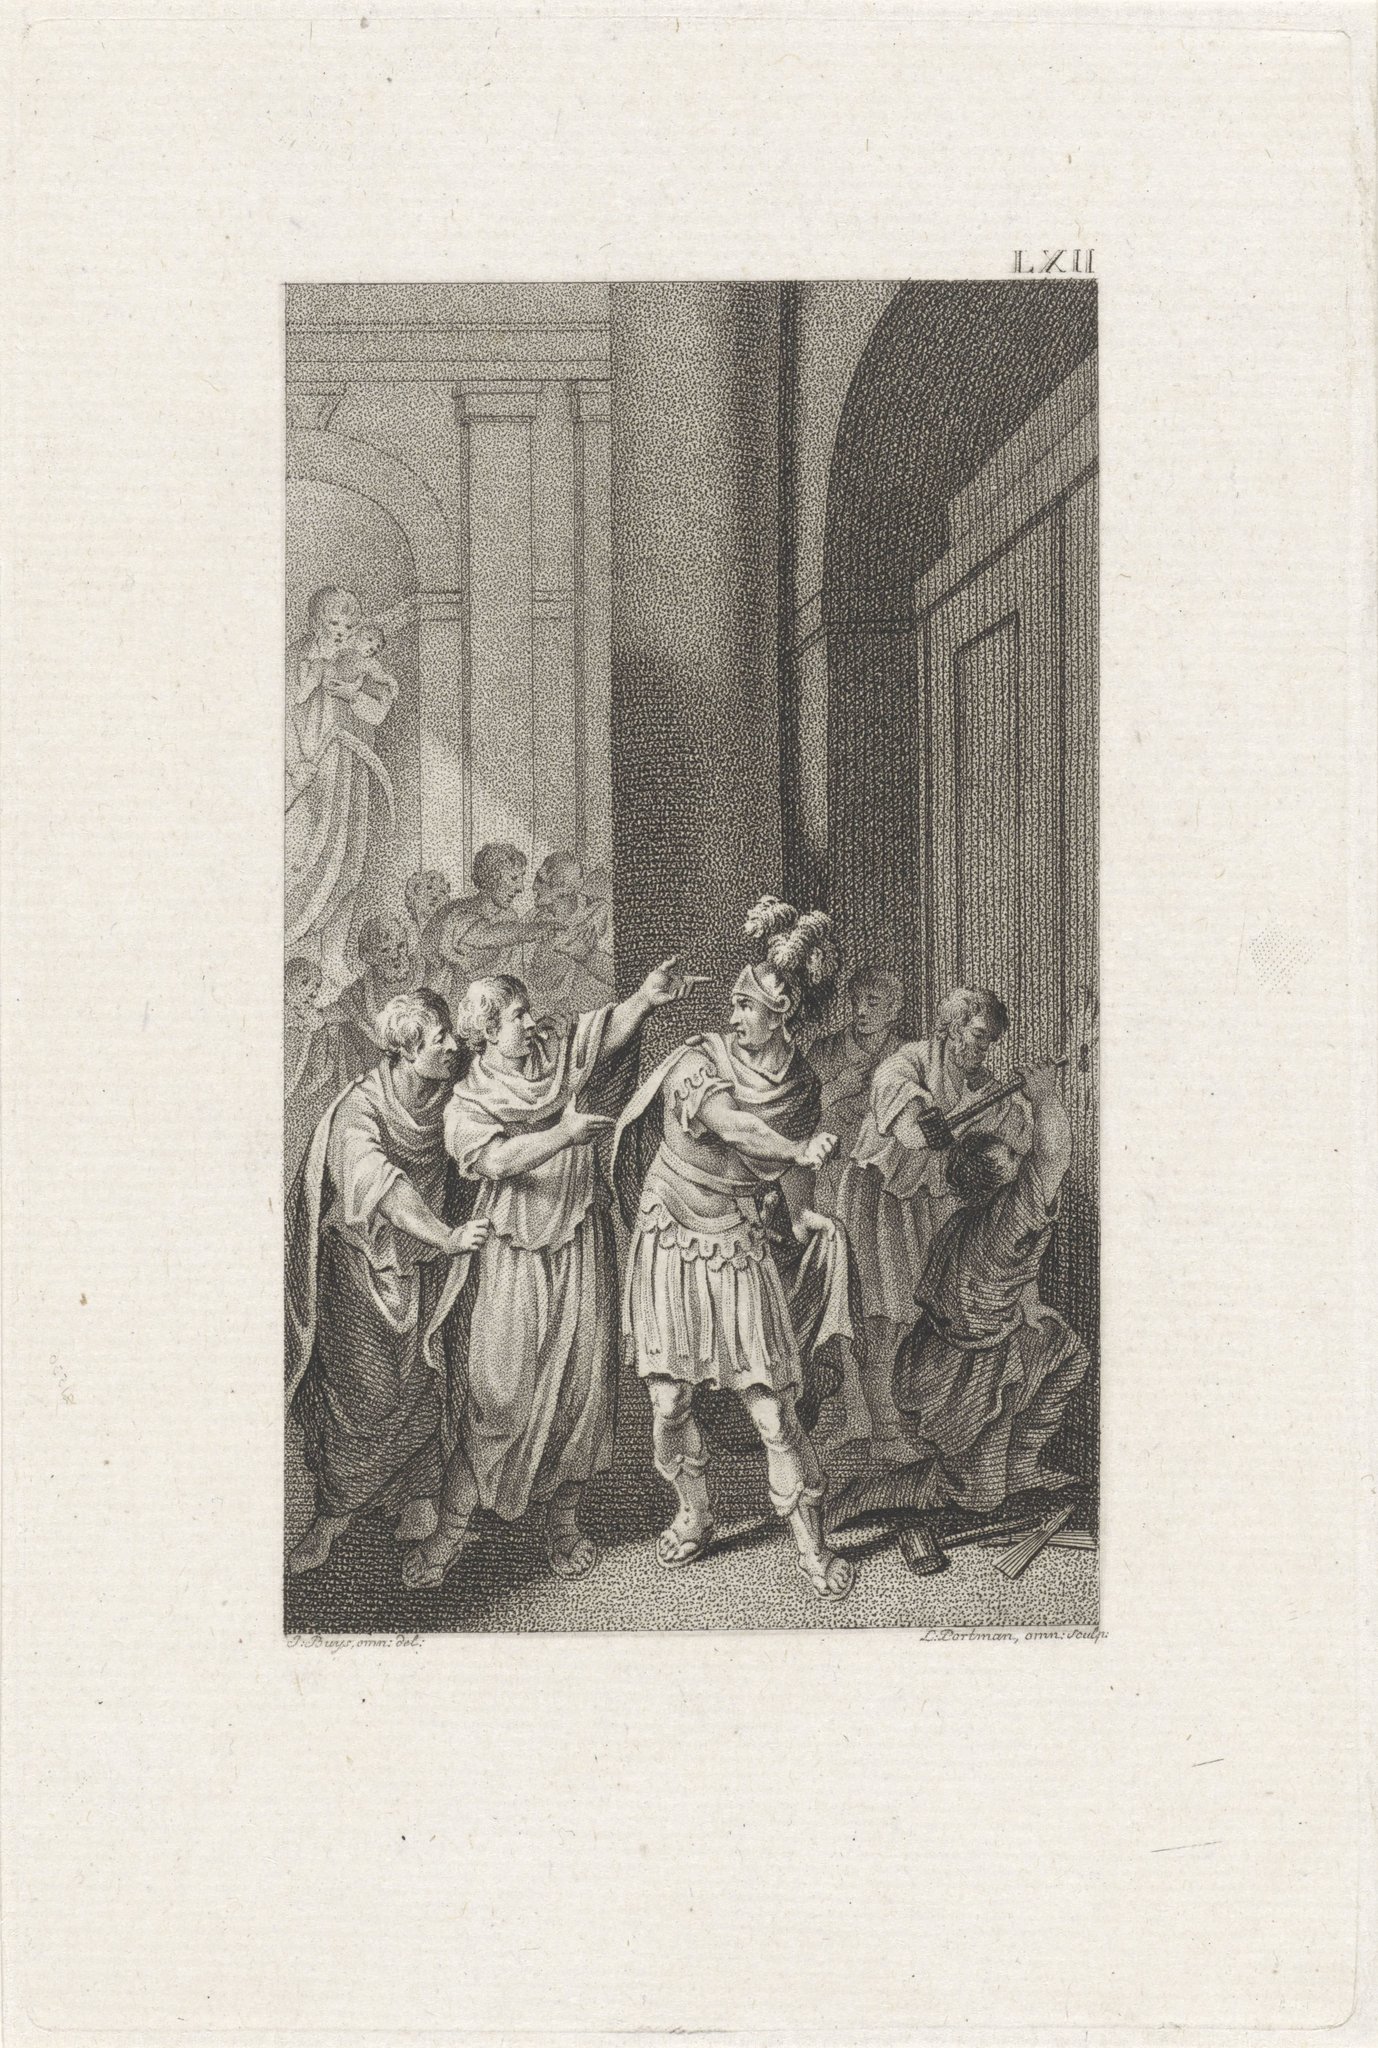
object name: book illustration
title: Caesar in de tempel van Saturnus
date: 1800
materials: paper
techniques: etching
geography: amsterdam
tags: aggressive relationships of c. julius caesar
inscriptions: collector's mark: Lugt 2228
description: In de tempel van Saturnus wordt Metellus door Caesar met de dood bedreigd. Caesar rooft alle kostbaarheden uit de tempel.